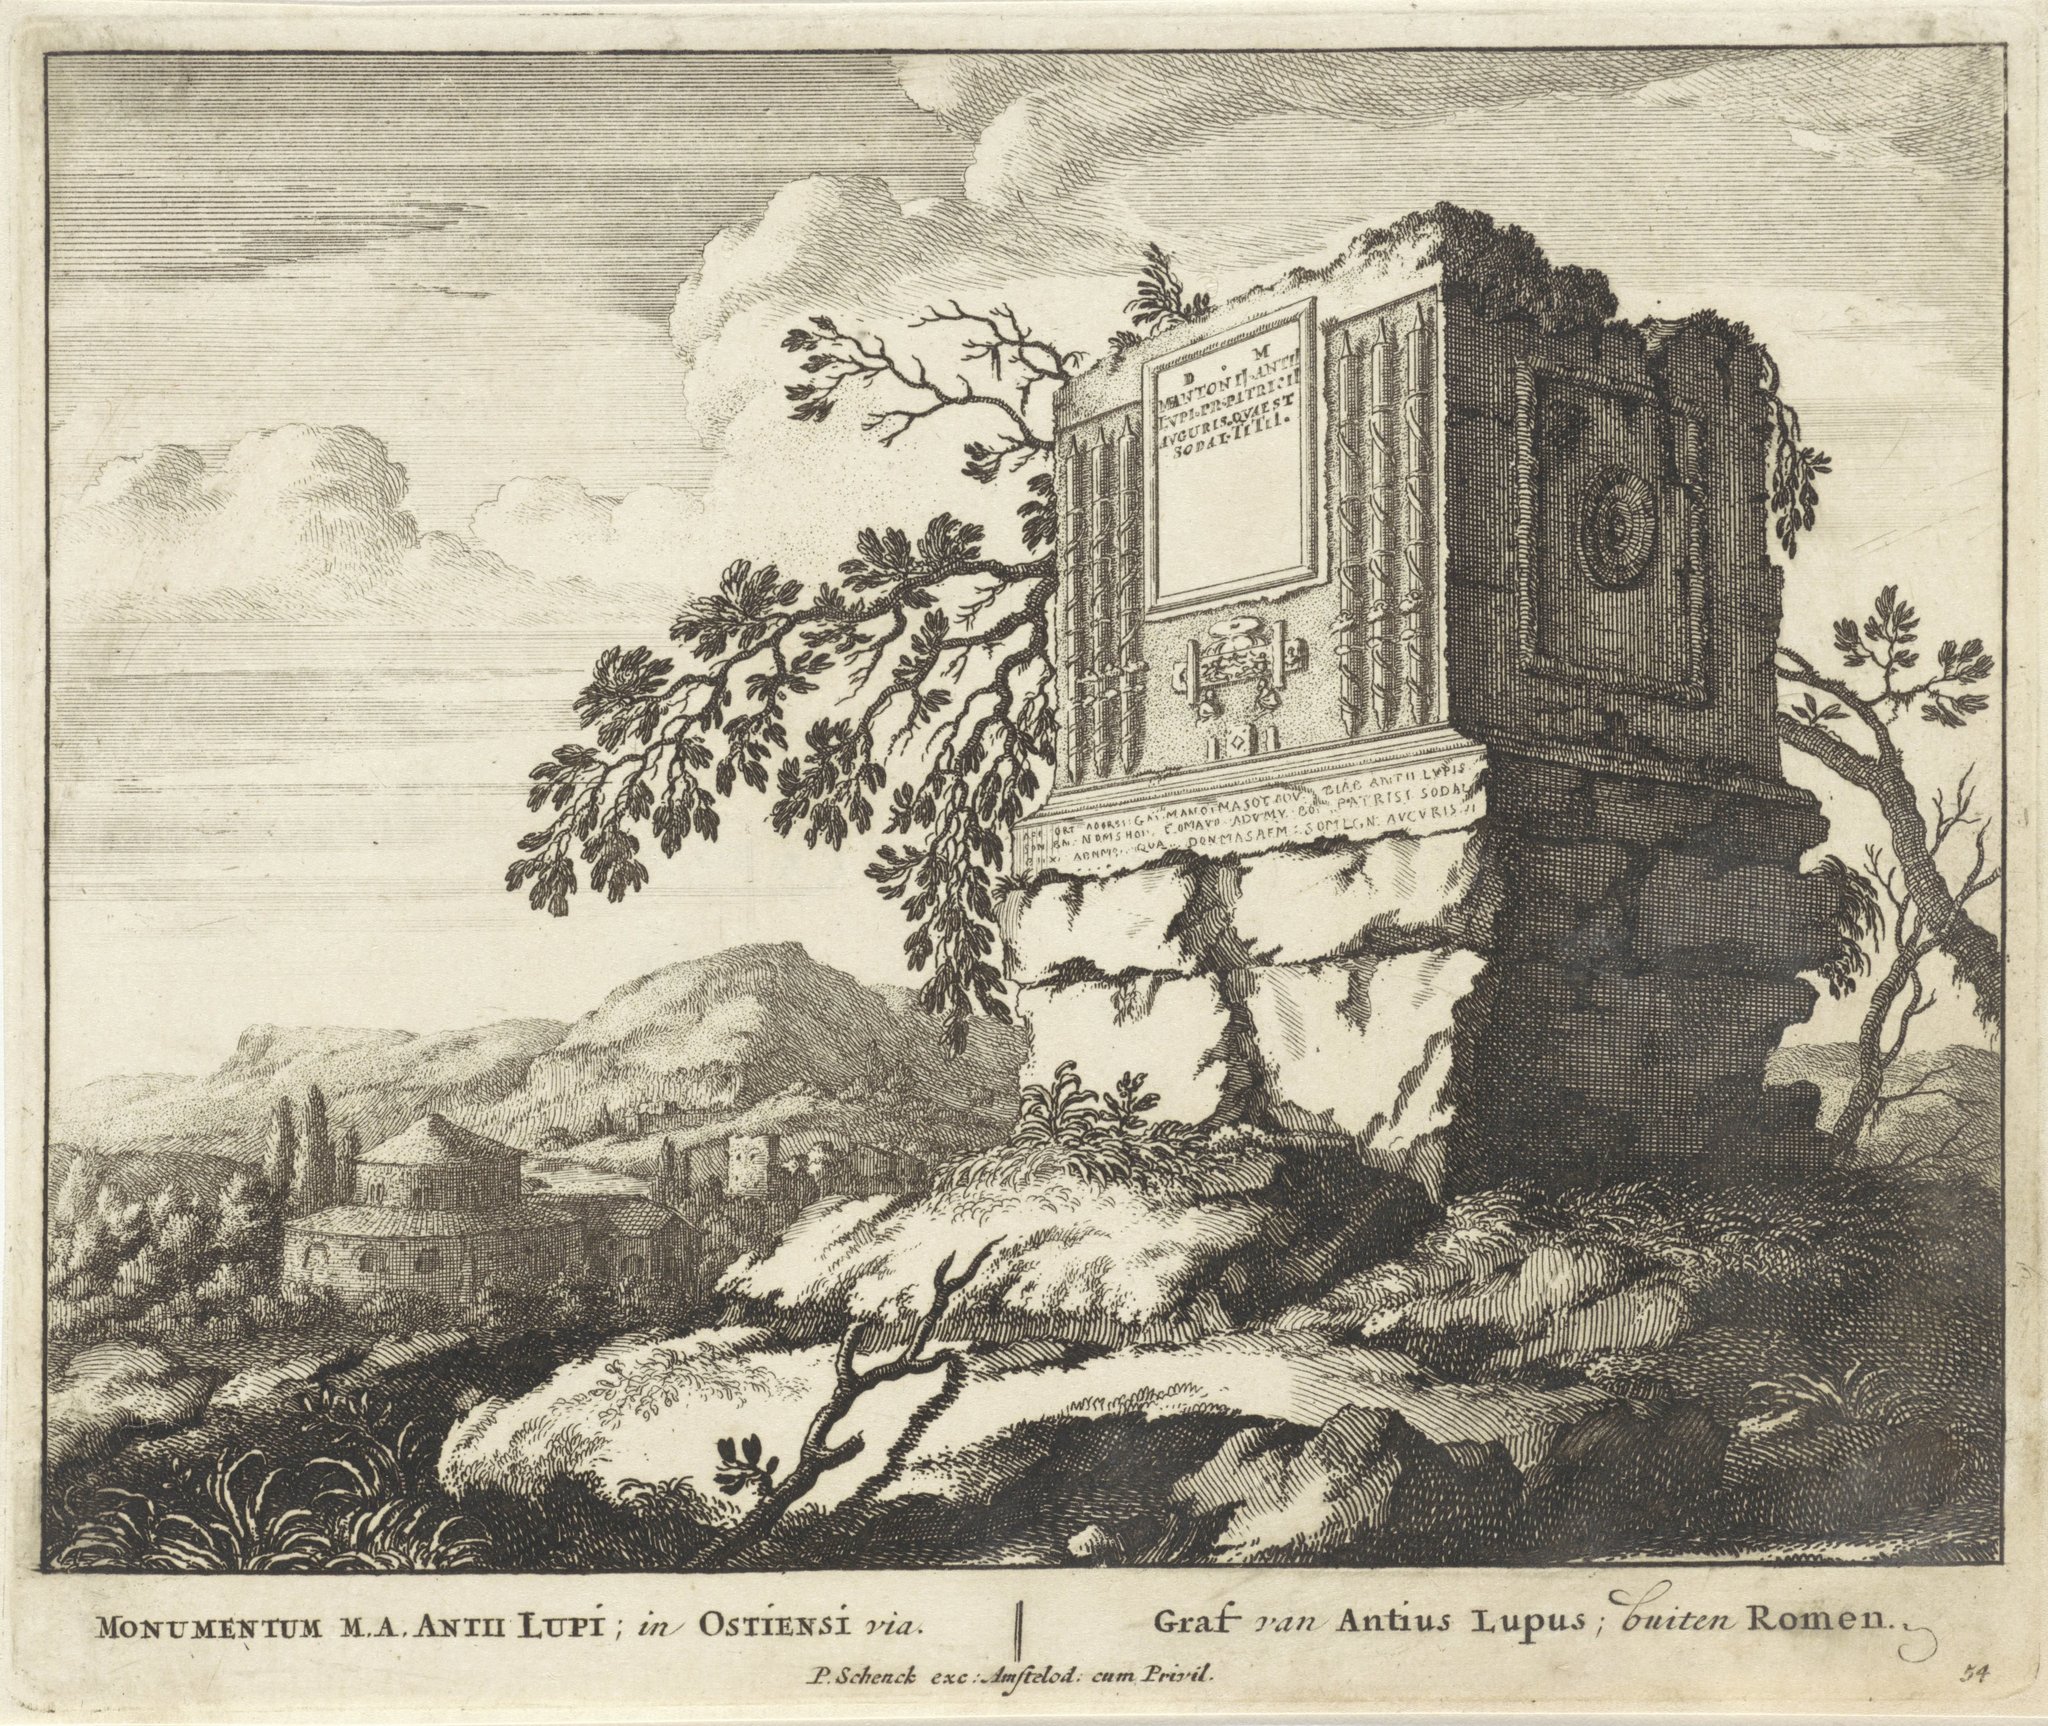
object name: print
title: Graf van Antius Lupus; buiten Romen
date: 1675-1711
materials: paper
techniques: etching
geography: amsterdam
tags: low hill country, grave, tomb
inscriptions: collector's mark: Lugt 2228